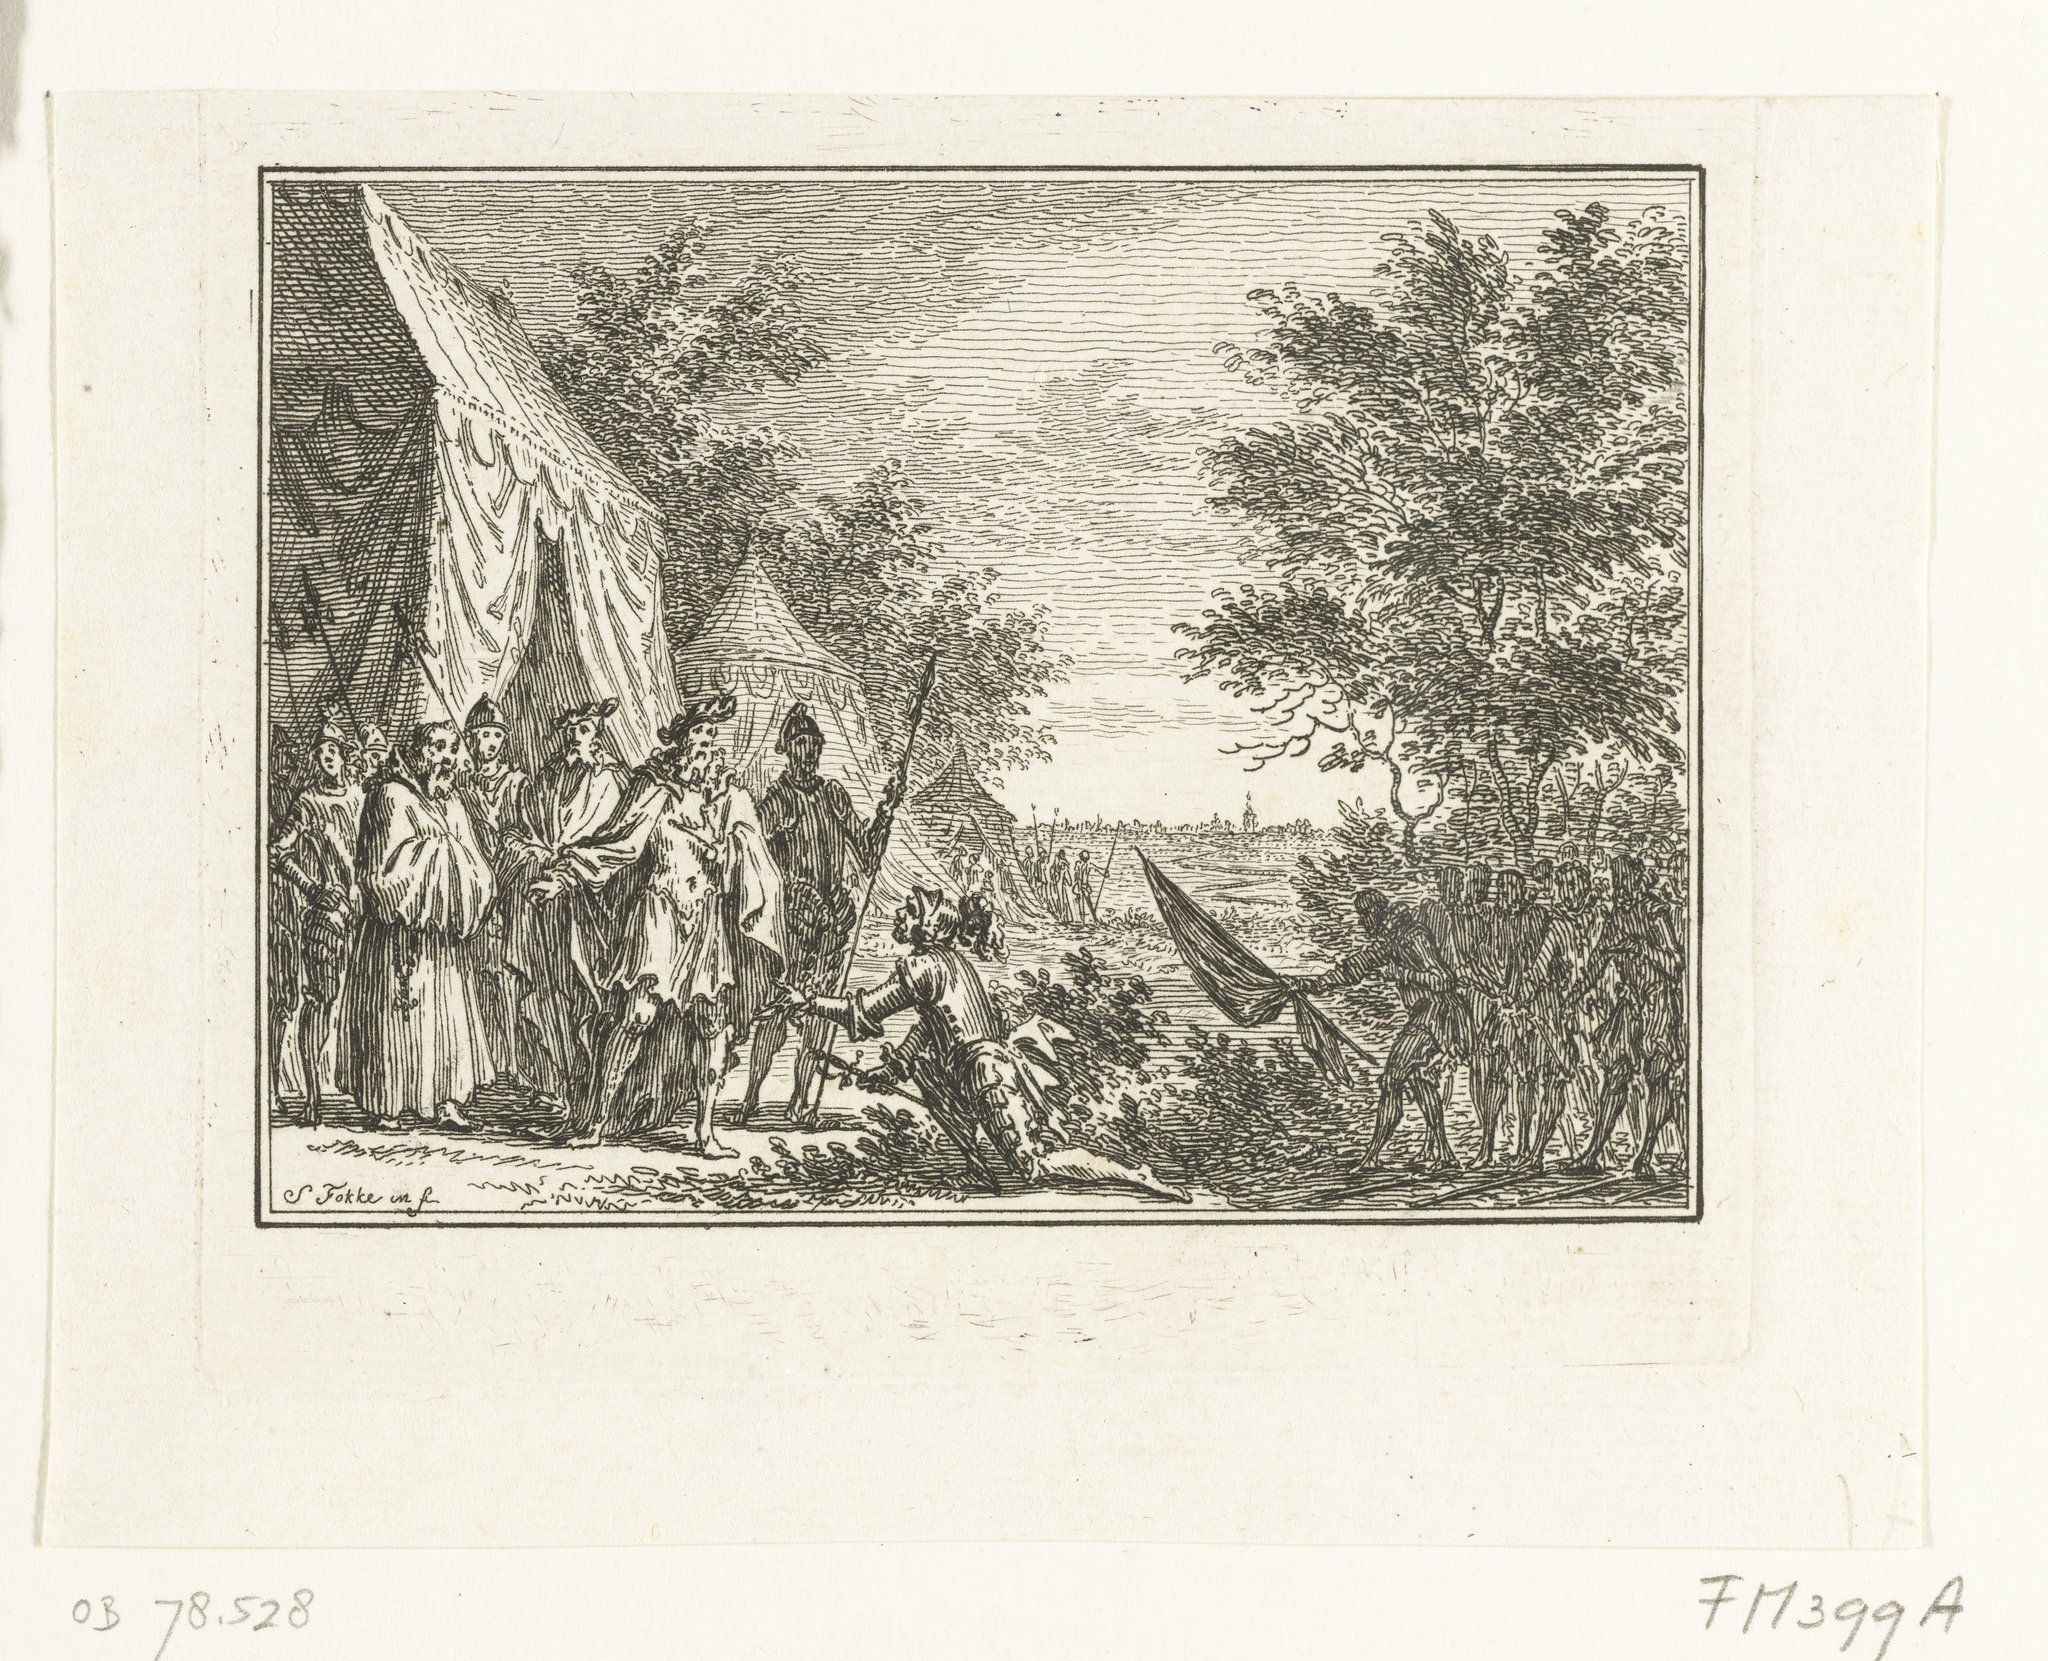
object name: history print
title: Willem II van Gelre onderwerpt zich aan keizer Karel V, 1543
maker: simon fokke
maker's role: draughtsman, print maker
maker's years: 1712-1784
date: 1782-1784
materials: paper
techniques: etching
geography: northern netherlands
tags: charles v (holy roman emperor and king of spain), defeat ~ armed conflict, netherlands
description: Illustratie voor: J.W. te Water, De vaderlandsche Historie van den heere J. Wagenaar, verkort, en met leerzaame aanmerkingen, ten dienste der Nederlandsche jeugd, 1784-1800, 4 delen. Staat vóór de letter. Niet in Frederik Muller; door het RPK toegevoegd nummer.